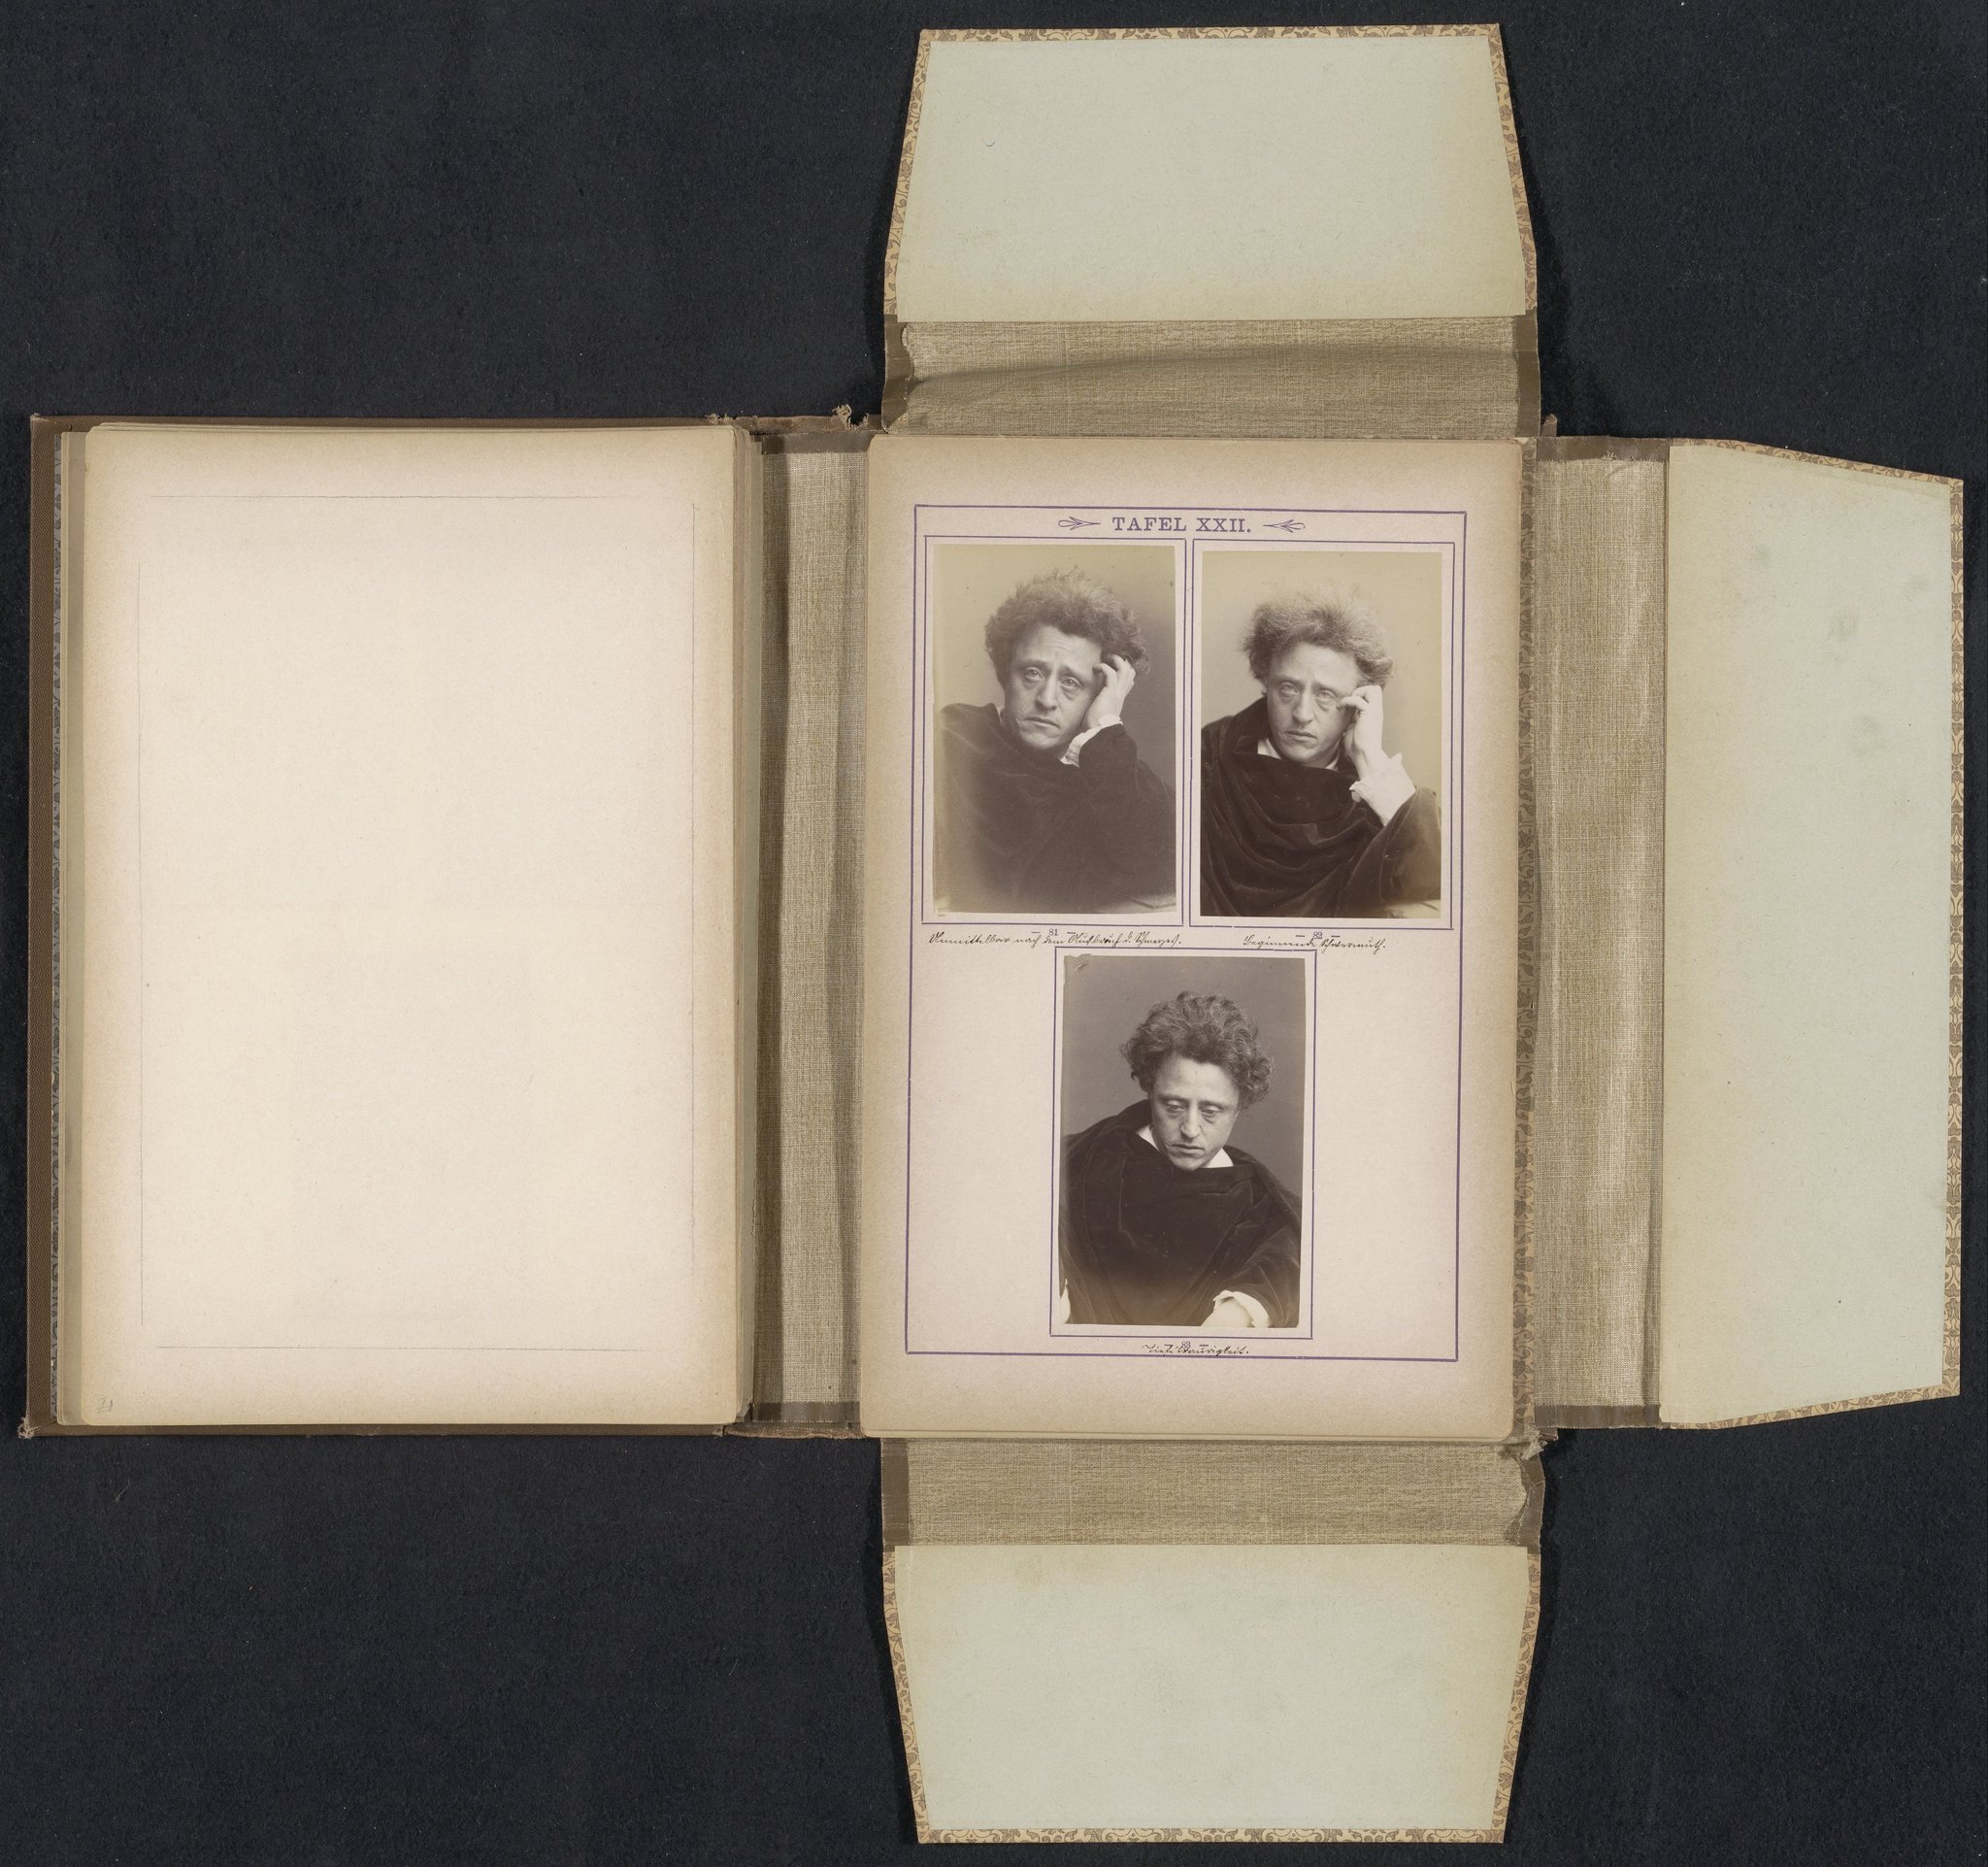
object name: page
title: Drie portretten van een man met gezichtsuitdrukkingen van pijn en weemoed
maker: nicola tonger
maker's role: fotograaf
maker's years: 1846-1917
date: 1881-1886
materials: cardboard, photographic support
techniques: albumen print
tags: pain, sorrow, sadness; 'dolore', 'dolore di zeusi' (ripa), morphology of facial expression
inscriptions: inscription: ‘Unmittelbar (...)Traurigkeit.’, number: ‘Tafel XXII.’, number: ‘81 (...) 83’